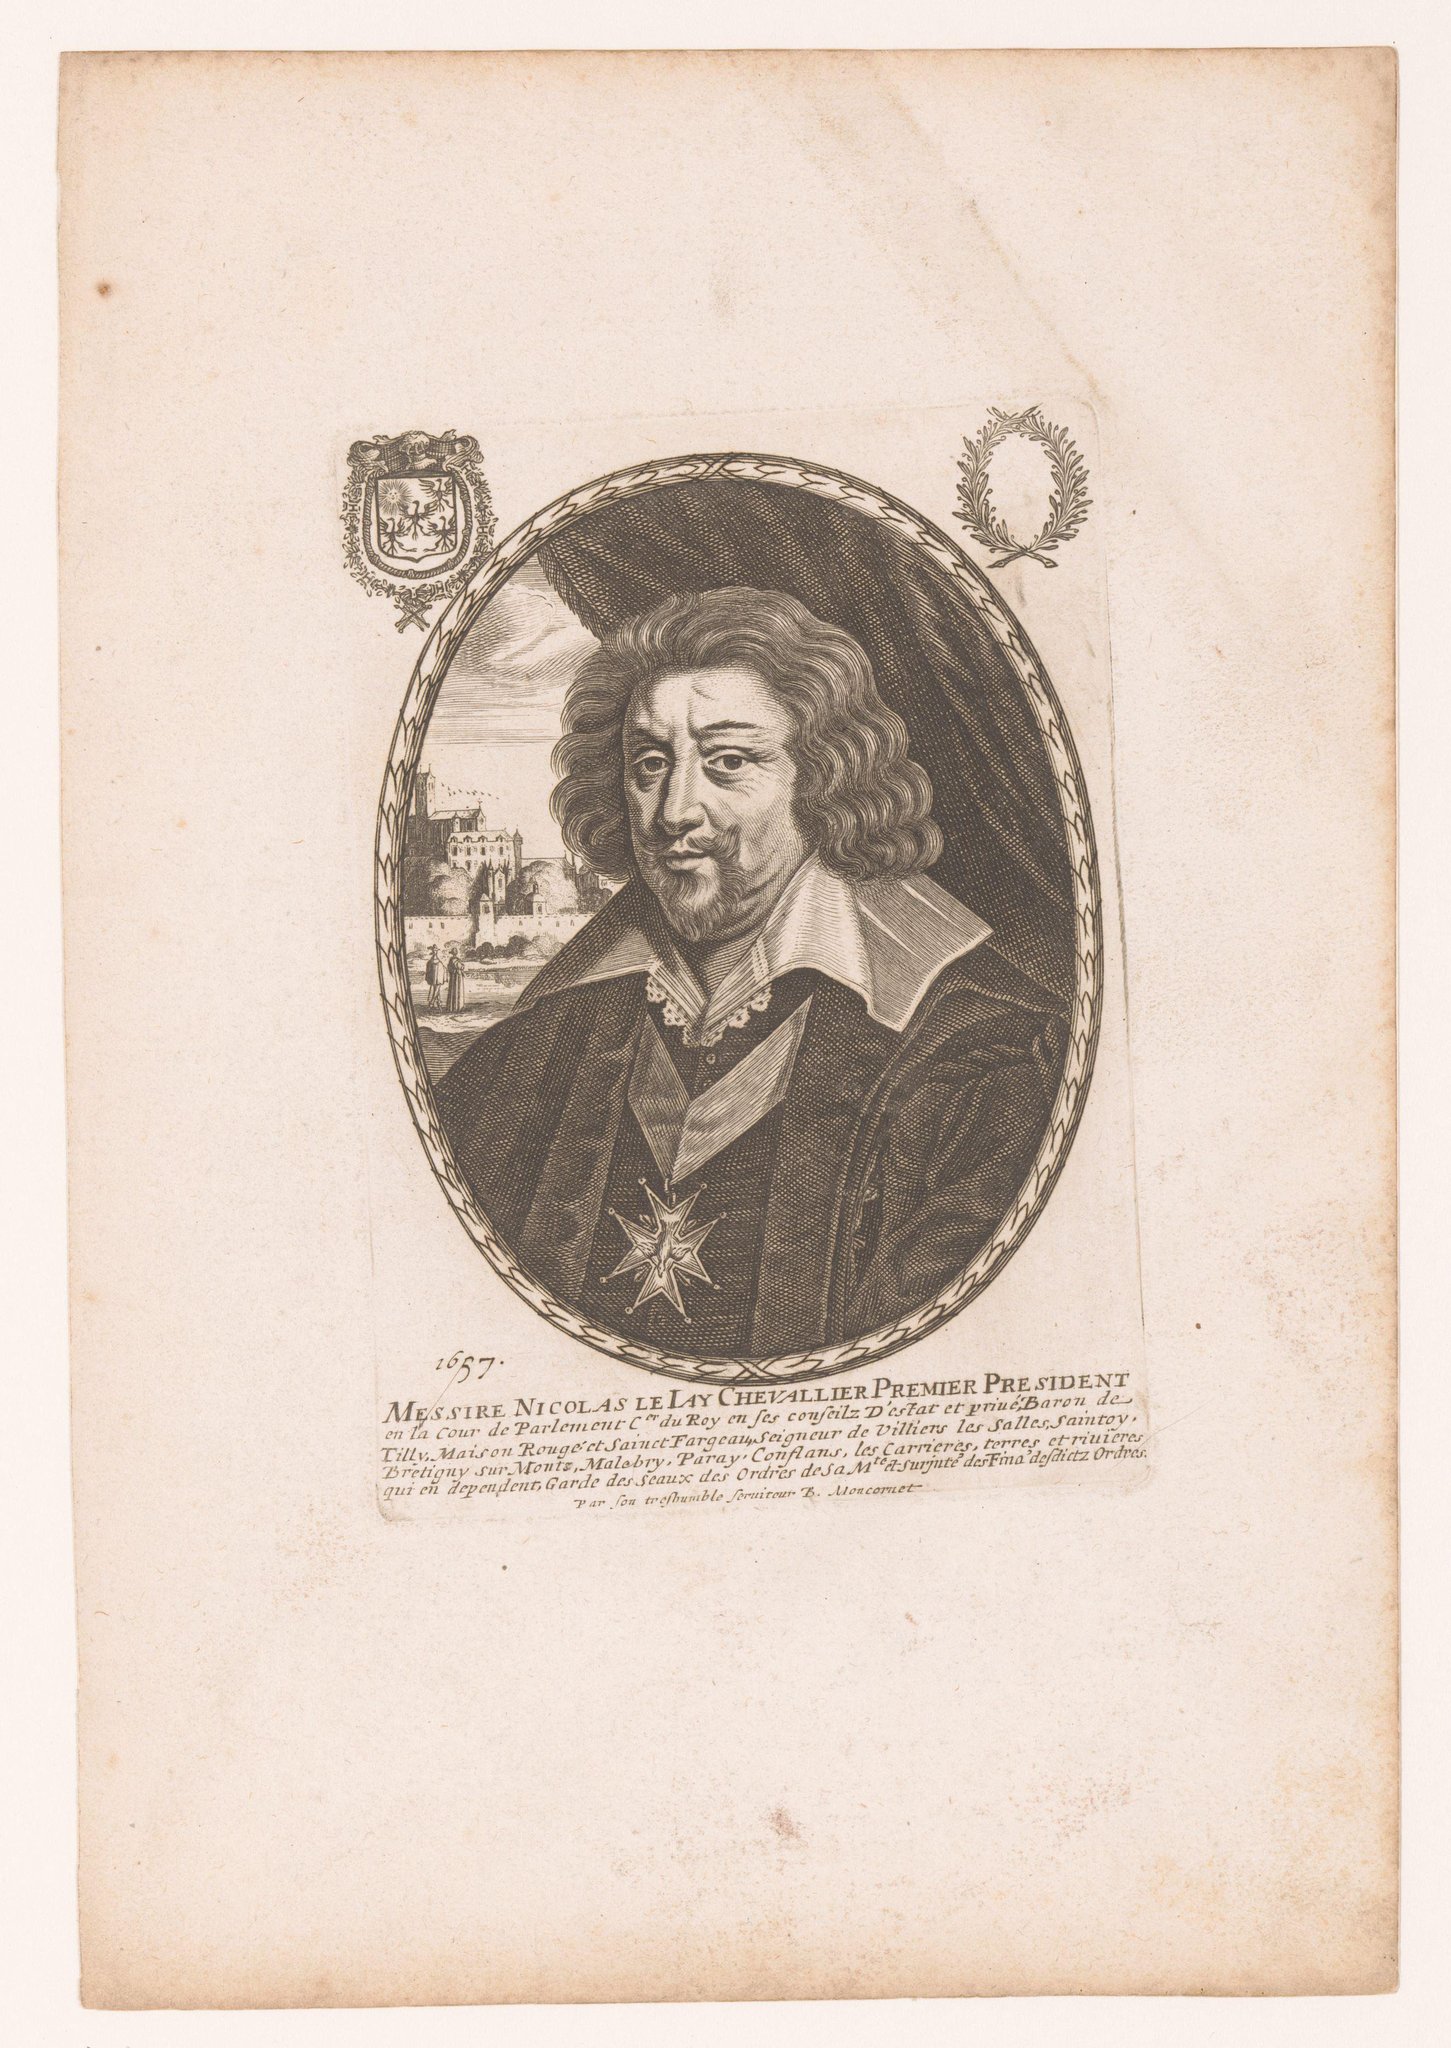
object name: print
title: Portret van Nicolas Le Jay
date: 1657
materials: paper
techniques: engraving, etching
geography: paris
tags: ranks in the army, historical persons, armorial bearing, heraldry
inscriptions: collector's mark: Lugt 2228